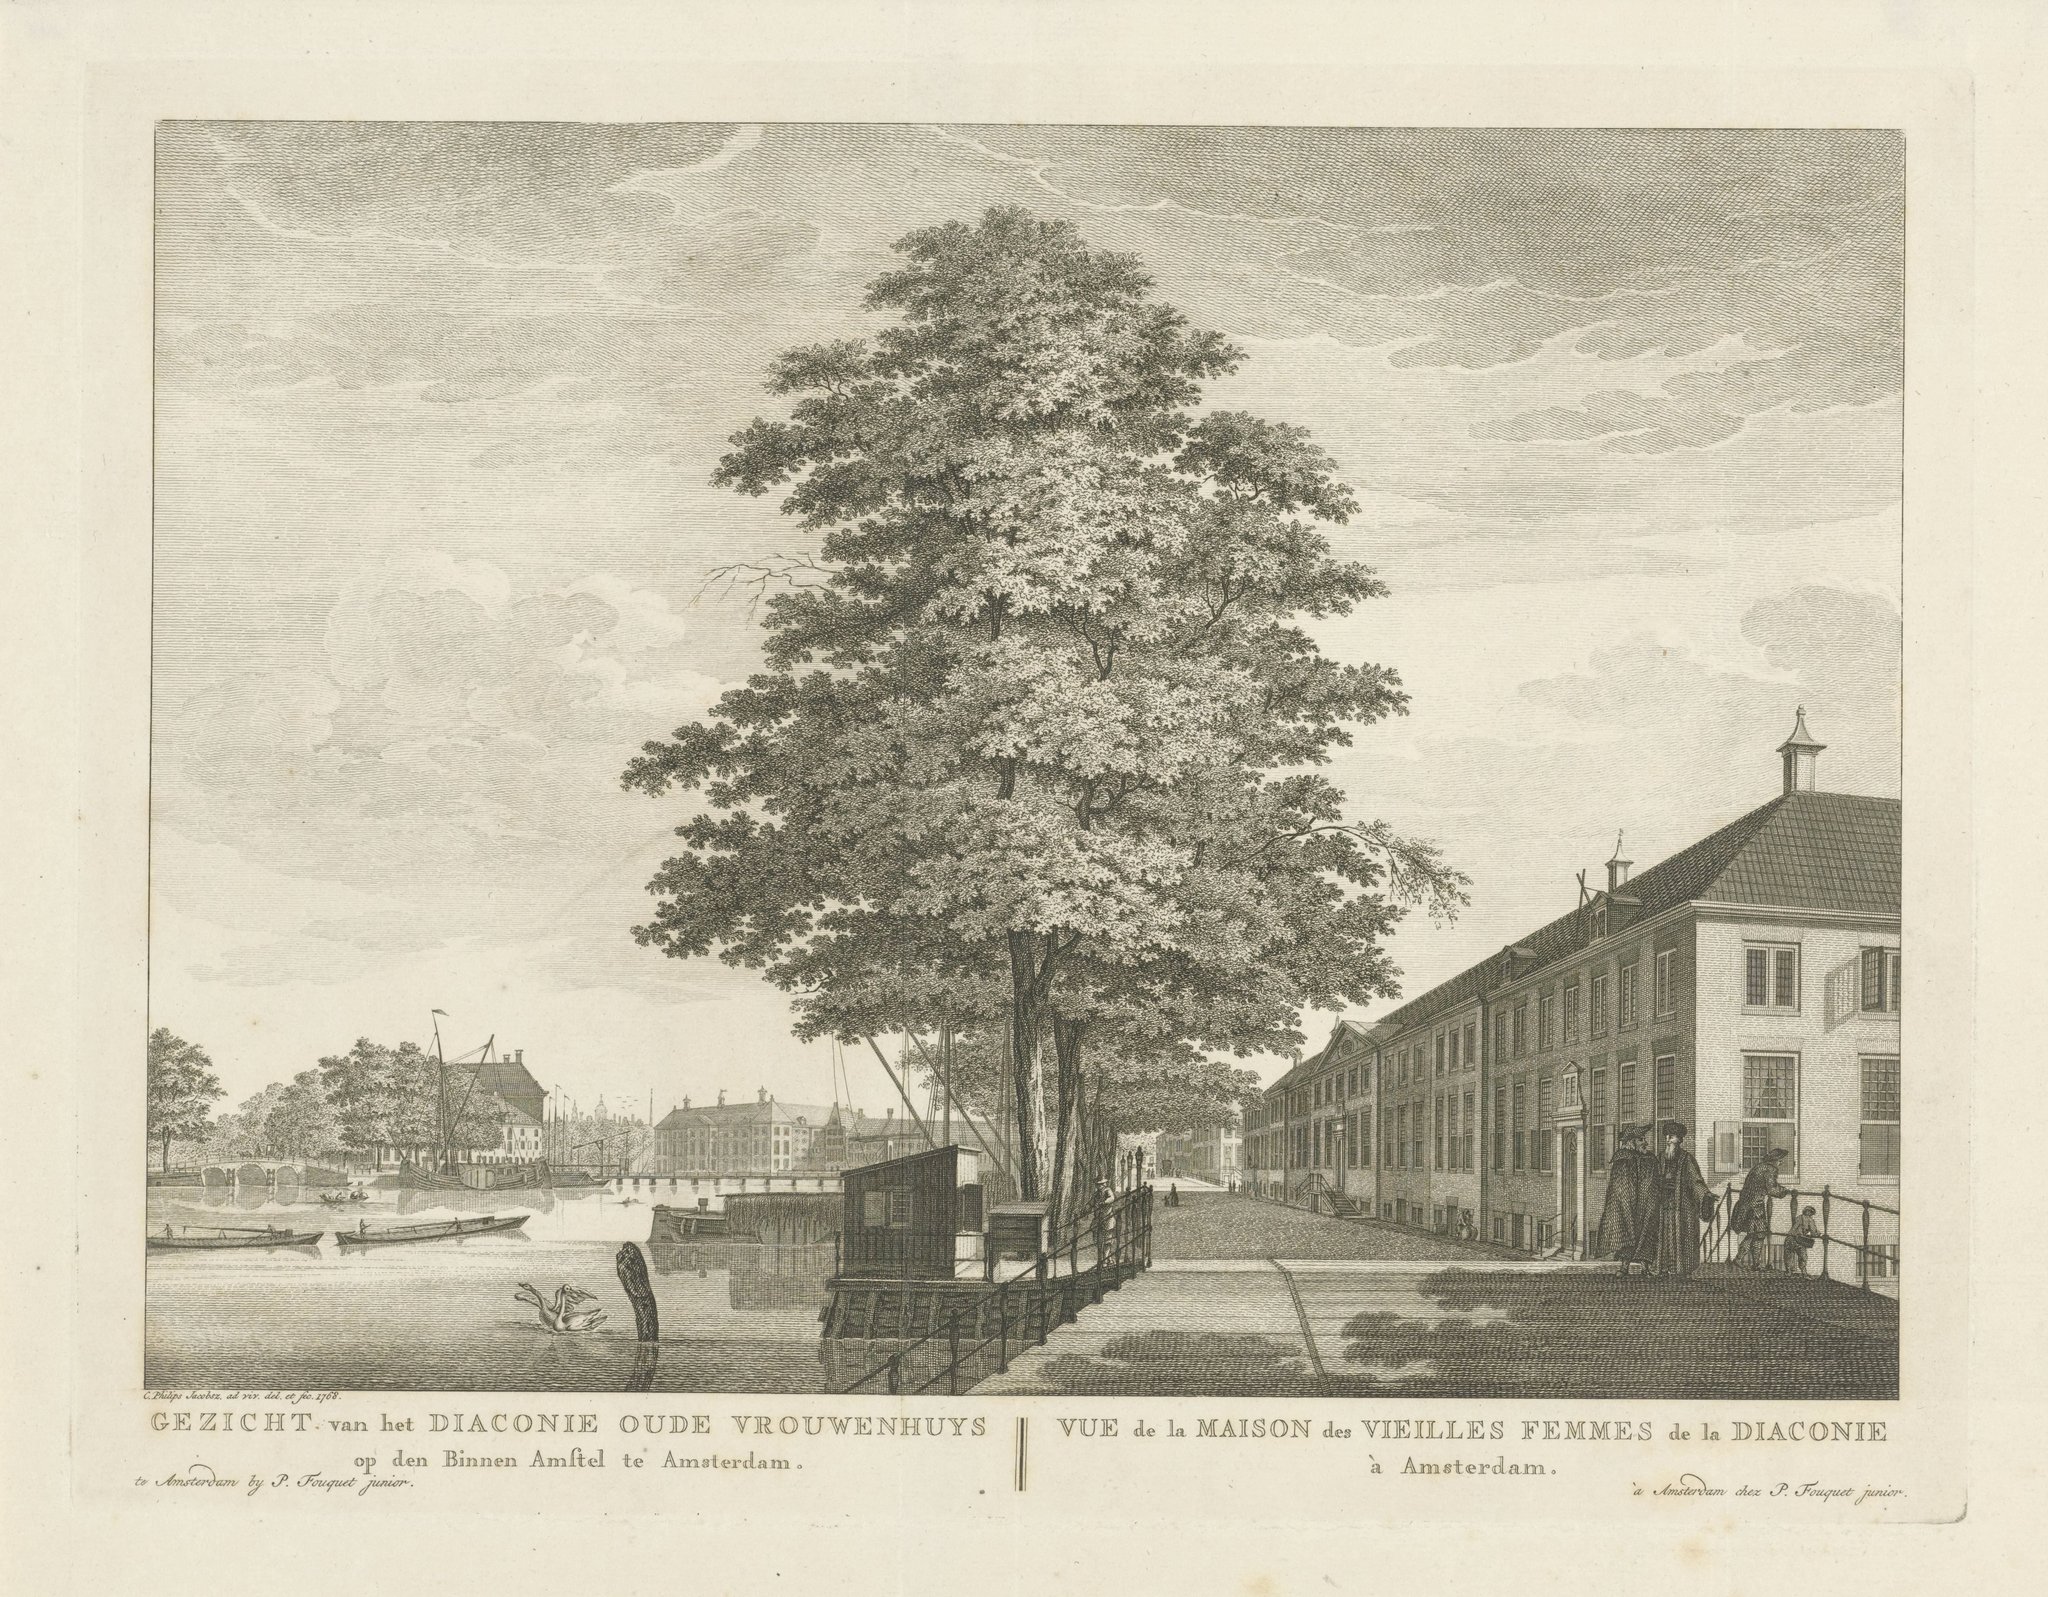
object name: print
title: Gezicht van het Diaconie Oude Vrouwenhuys op den Binnen Amstel te Amsterdam / Vue de la Maison des Vieilles Femmes de la Diaconie à Amsterdam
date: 1768-1783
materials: paper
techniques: engraving, etching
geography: amsterdam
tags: bridge in city across river, canal, etc. (+ city(-scape) with figures, staffage), public welfare, orphanage, canals, waters (in city) (+ city(-scape) with figures, staffage), old-people's home, street (+ city(-scape) with figures, staffage)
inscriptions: collector's mark: Lugt 2228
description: Deze prent is ook gebruikt in de zogenaamde Atlas van Fouquet.* Pierre Fouquet gaf vanaf 1760 stadsgezichten van Amsterdam - naar tekeningen van verschillende kunstenaars, gemaakt door verschillende prentmakers - uit. Deze prenten werden aanvankelijk los of in series verkocht. Zoals toen gebruikelijk kon de koper de prenten zelf laten inbinden. Hiertoe gaf Fouquet tussen 1778 en 1783 een titelblad, plattegrond en inhoudsopgave van de tot dusver 100 uitgegeven prenten uit (1). Gezien de inhoud afhankelijk was van wat de koper had verzameld verschilt de inhoud van de verschillende bewaarde Fouquetatlassen onder deze titel sterk. Ook zijn er exemplaren bekend waar tevens andere prenten aan zijn toegevoegd. Omdat er behoefte bleek aan uitleg bij de platen werd in 1783 een nieuwe versie van de atlas uitgegeven, aangevuld met tekst en twee prenten. De aangegeven volgorde veranderde maar de platen van de al eerder uitgegeven prenten bleven ongewijzigd. Deze uitgave werd in opdracht van Fouquet gedrukt bij Daniël Jean Changuion en Petrus den Hengst (2). Een tiental platen werd bijgewerkt en verscheen, met nieuw impressum, in het vervolg van Wagenaars geschiedenis van Amsterdam, uitgeven door Petrus Conradi en Folkert van der Plaats (3). Een aantal jaar na het overlijden van Fouquet kwam Evert Maaskamp met een nieuwe uitgave van de atlas, met verbeterde tekst en toevoeging van twee prenten. Op alle platen verwijderde hij het oude en liet hij zijn eigen impressum zetten (4). De huidige staat van de prent komt voor in exemplaren van de onder (1) en (2) genoemde werken. * Onder de Atlas van Fouquet of Fouquetatlas verstaan we de hieronder vermelde publicaties (1), (2) en (4). (1). Afbeeldingen van de wyd-vermaarde koopstad Amsterdam benevens des zelvs voornaamste gebouwen en gezigten alle naar het leeven getekend / Receuil des edifices les plus considerables et des plus belles vues, de la fameuse ville d'Amsterdam, dessinées d'après nature. Amsterdam: Pierre Fouquet, 1778-1783. (2). Nieuwe atlas, van de voornaamste gebouwen en gezigten der stad Amsterdam, met derzelver beknopte beschryvingen. 2 delen. Amsterdam: Daniël Jean Changuion en Petrus den Hengst [in opdracht van Pierre Fouquet], 1783. (3). Stijl, Simon. Amsterdam, in zyne geschiedenissen, voorregten, koophandel, gebouwen, kerkenstaat, schoolen, schutterye, gilden en regeeringe, beschreeven. Om te dienen ten vervolge op het werk van Jan Wagenaar (…). 10 delen. Amsterdam en Harlingen: Petrus Conradi en Folkert van der Plaats, 1788-1801. (4). Nieuwe atlas, van de voornaamste gebouwen en gezigten der stad Amsterdam. Met derzelver beknopte beschryvingen. Amsterdam: Evert Maaskamp, 1805. * Het aantal vermelde staten is gebaseerd op het aantal gevonden staten. Mogelijk zijn er meer staten van deze prent. Voor eerste bekende staat zie RP-P-1921-578. Voor derde bekende staat zie RP-P-AO-26-39A, RP-P-1931-102 en RP-P-1998-754.